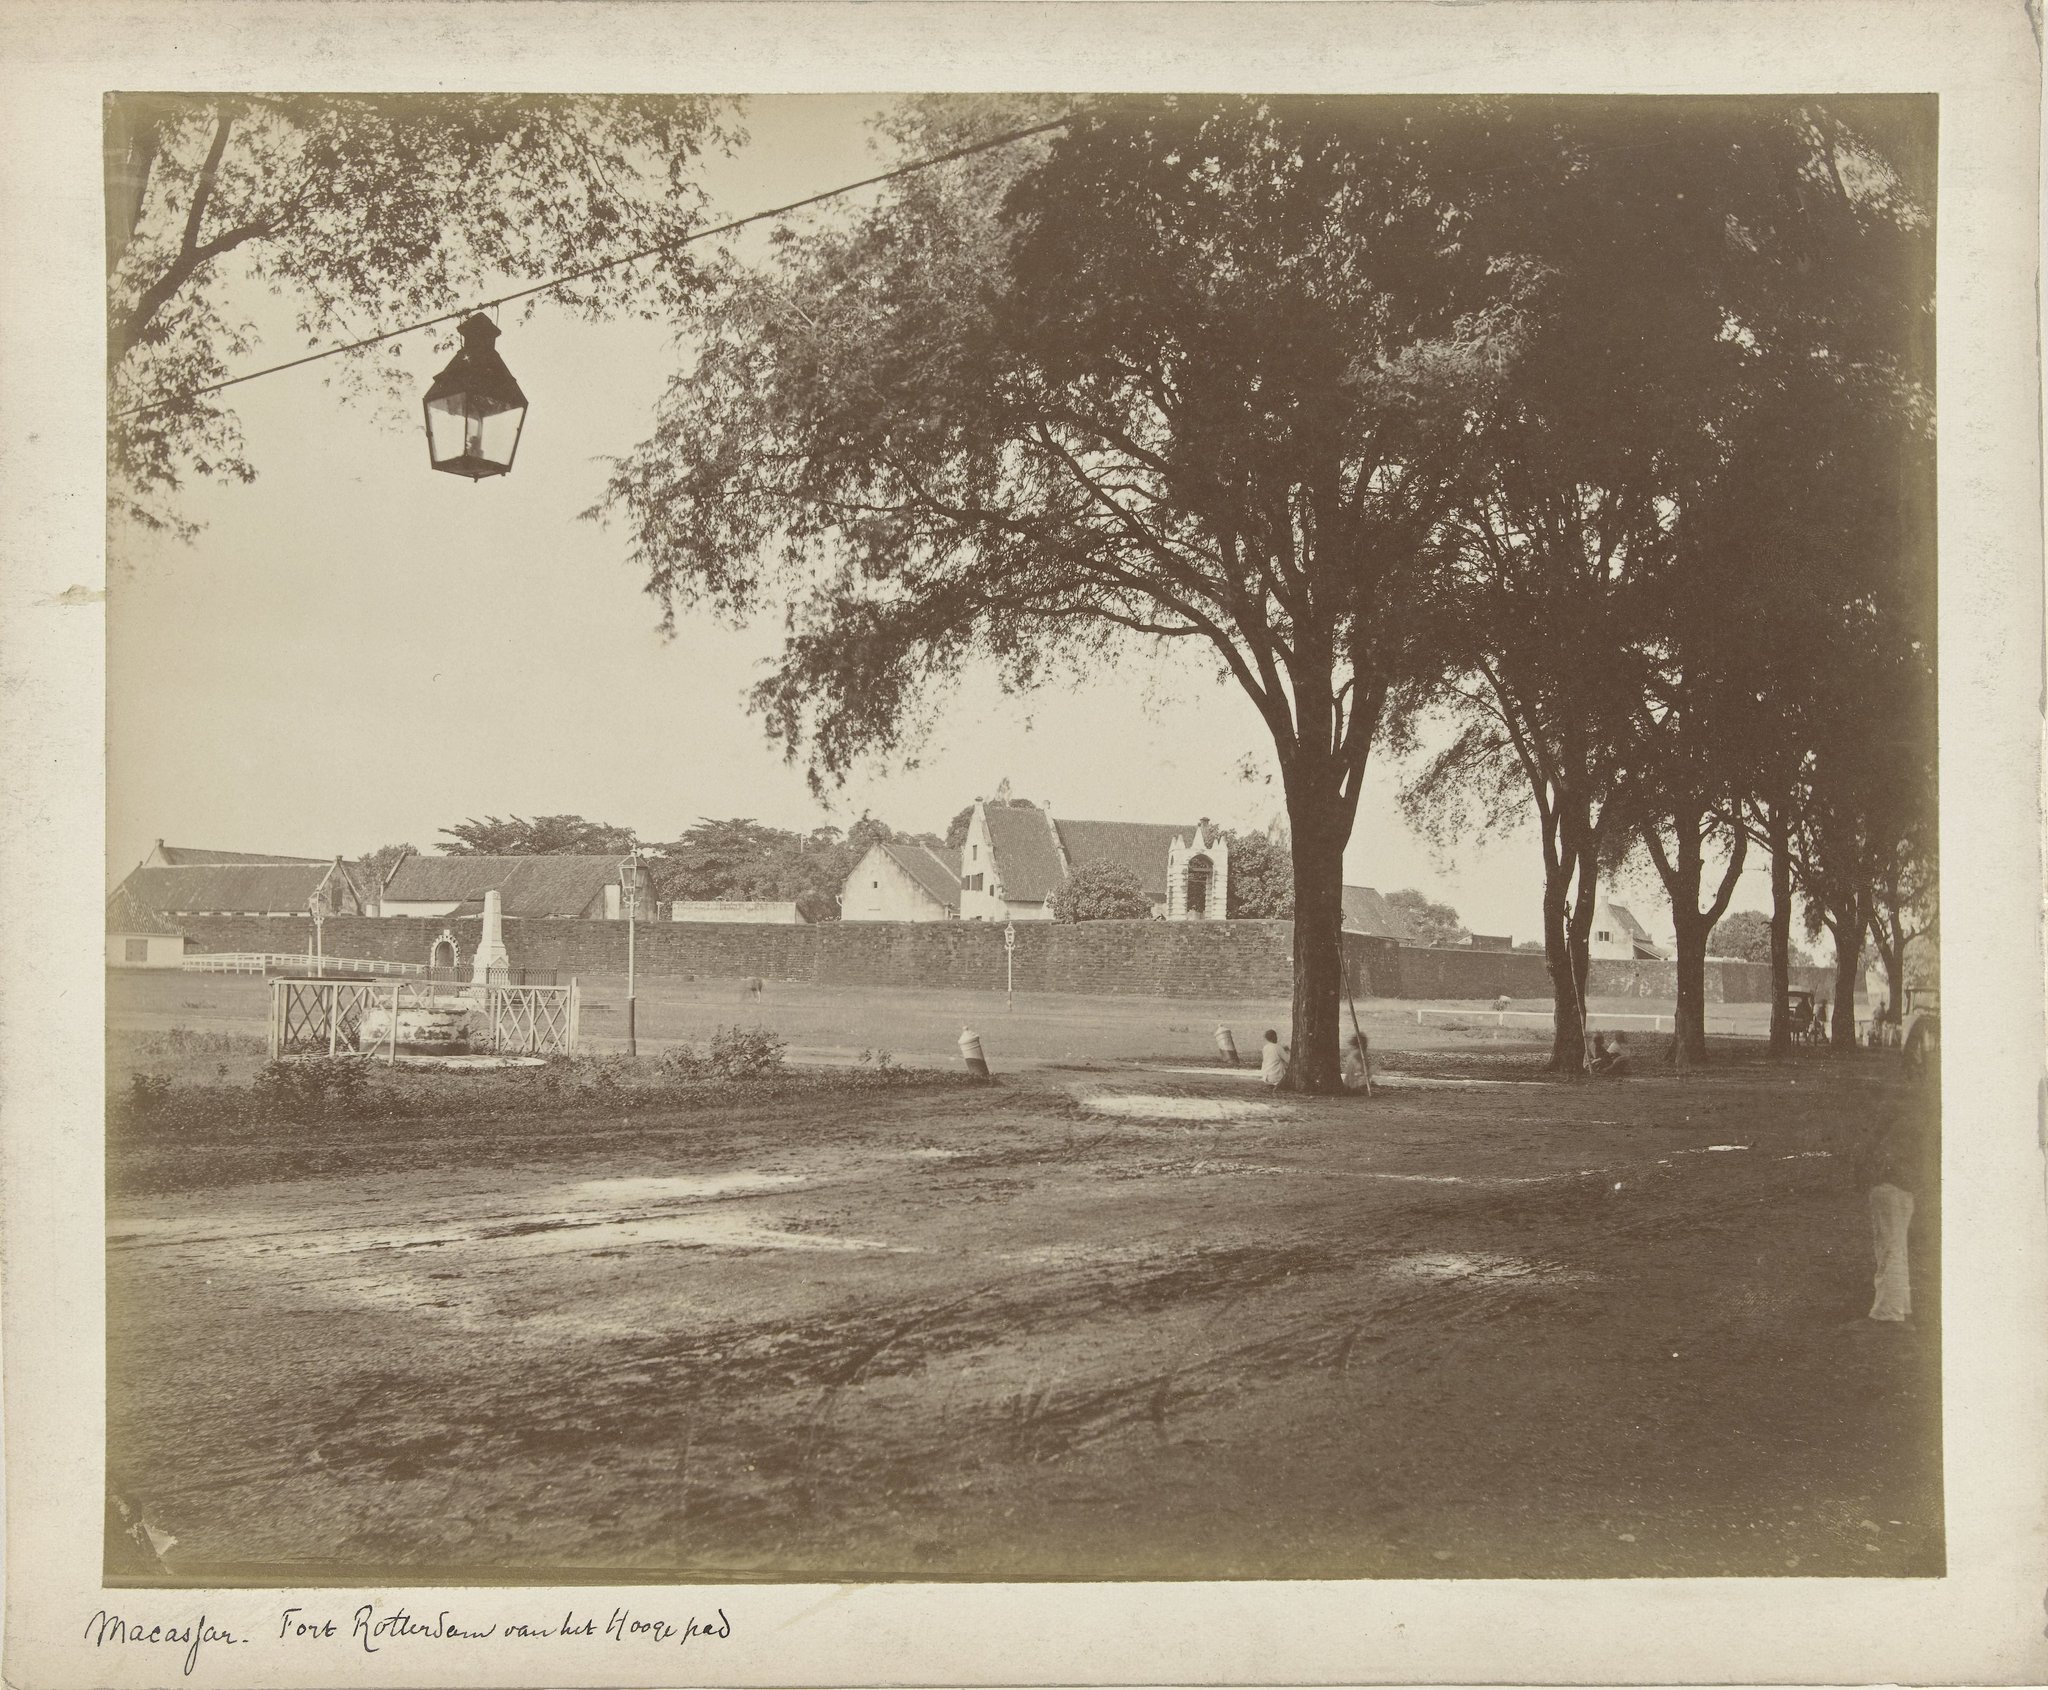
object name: photograph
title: Fort Rotterdam in Makassar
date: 1855-1880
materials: cardboard, paper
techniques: albumen print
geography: makassar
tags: diponegoro, fortress, public road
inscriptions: inscription: ‘Macassar. Fort Rotterdam van het Hooge pad’, number: ‘31’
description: Fort Rotterdam in Makassar. In het tweede gebouw van links binnen de muren hield Diponegoro kwartier.